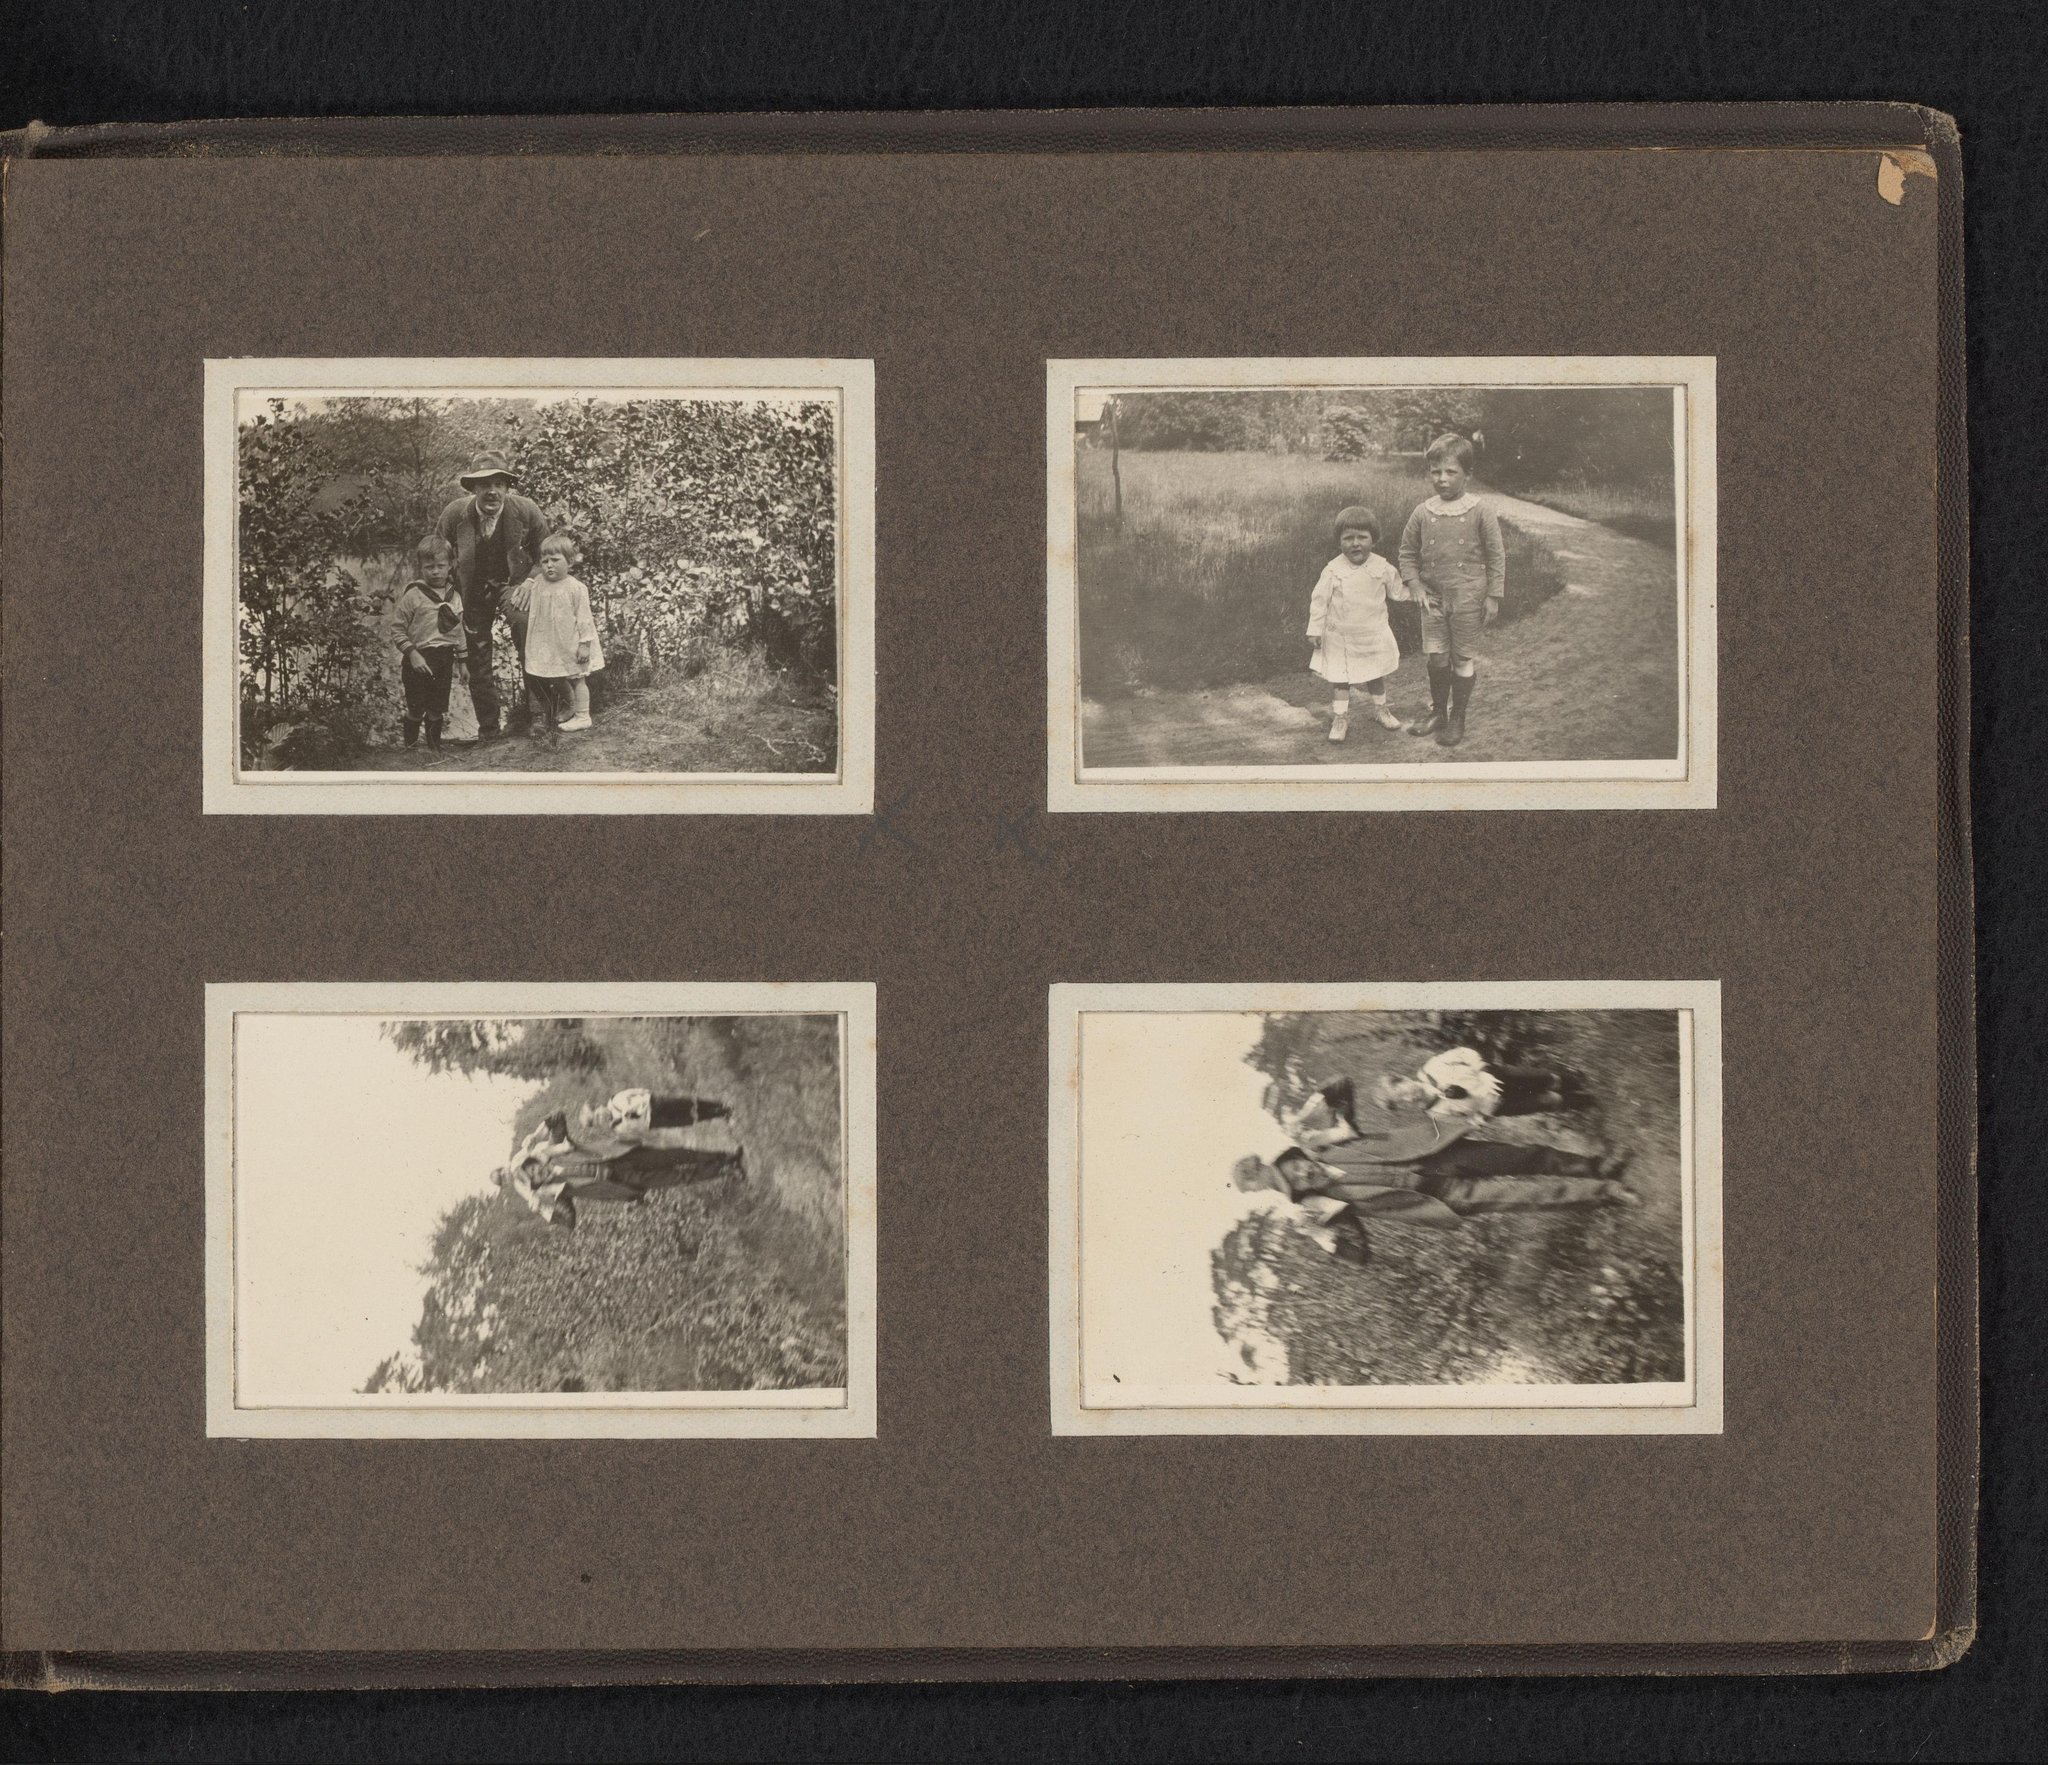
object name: photograph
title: Vier foto's van de familie Van den Berg in het bos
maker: hendrik herman van den berg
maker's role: amateurfotograaf, jurist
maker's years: 1875-1944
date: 1914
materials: paper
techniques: gelatin silver print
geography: netherlands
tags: batavia, hendrik herman van den berg, carel frederik van den berg (cay), amsterdam, frank willem van den berg (1912-1998), forest, wood, father and child(ren), man and child(ren) (family group), netherlands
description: Deze foto's maken deel uit van een album.